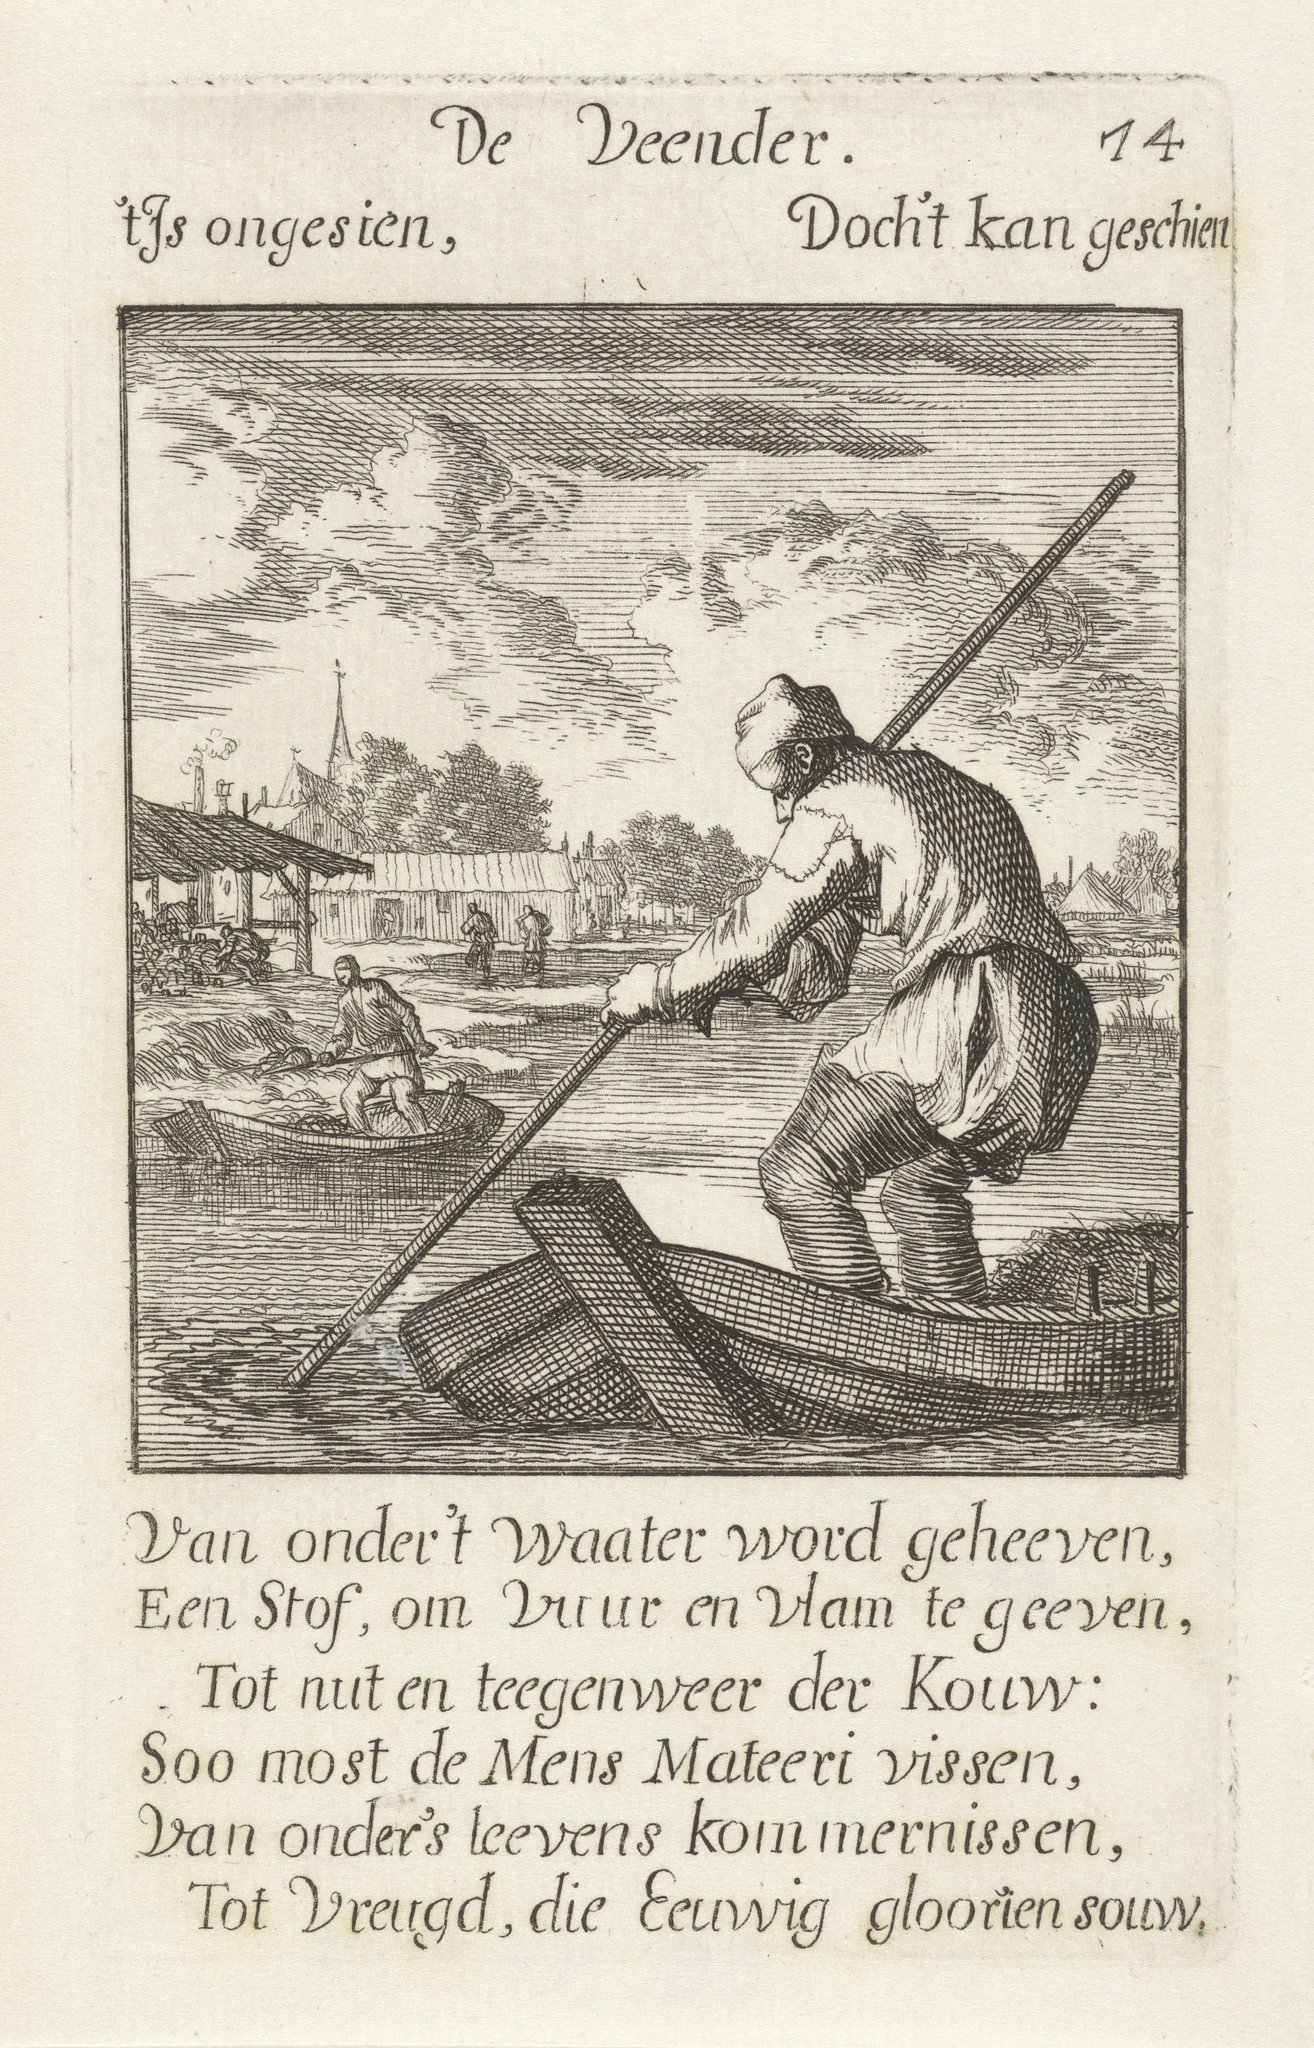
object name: print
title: Veengraver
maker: jan luyken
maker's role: draughtsman, print maker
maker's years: 1649-1712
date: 1694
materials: paper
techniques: etching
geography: amsterdam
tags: handicrafts, craftsman at work, peat-cutting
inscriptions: collector's mark: Lugt 2228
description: Maakt deel uit van de 100-delige serie beroepsprenten van Jan en Caspar Luyken, getiteld: Het menselyk bedryf. S.l.s.n., 1694 (eerste druk).